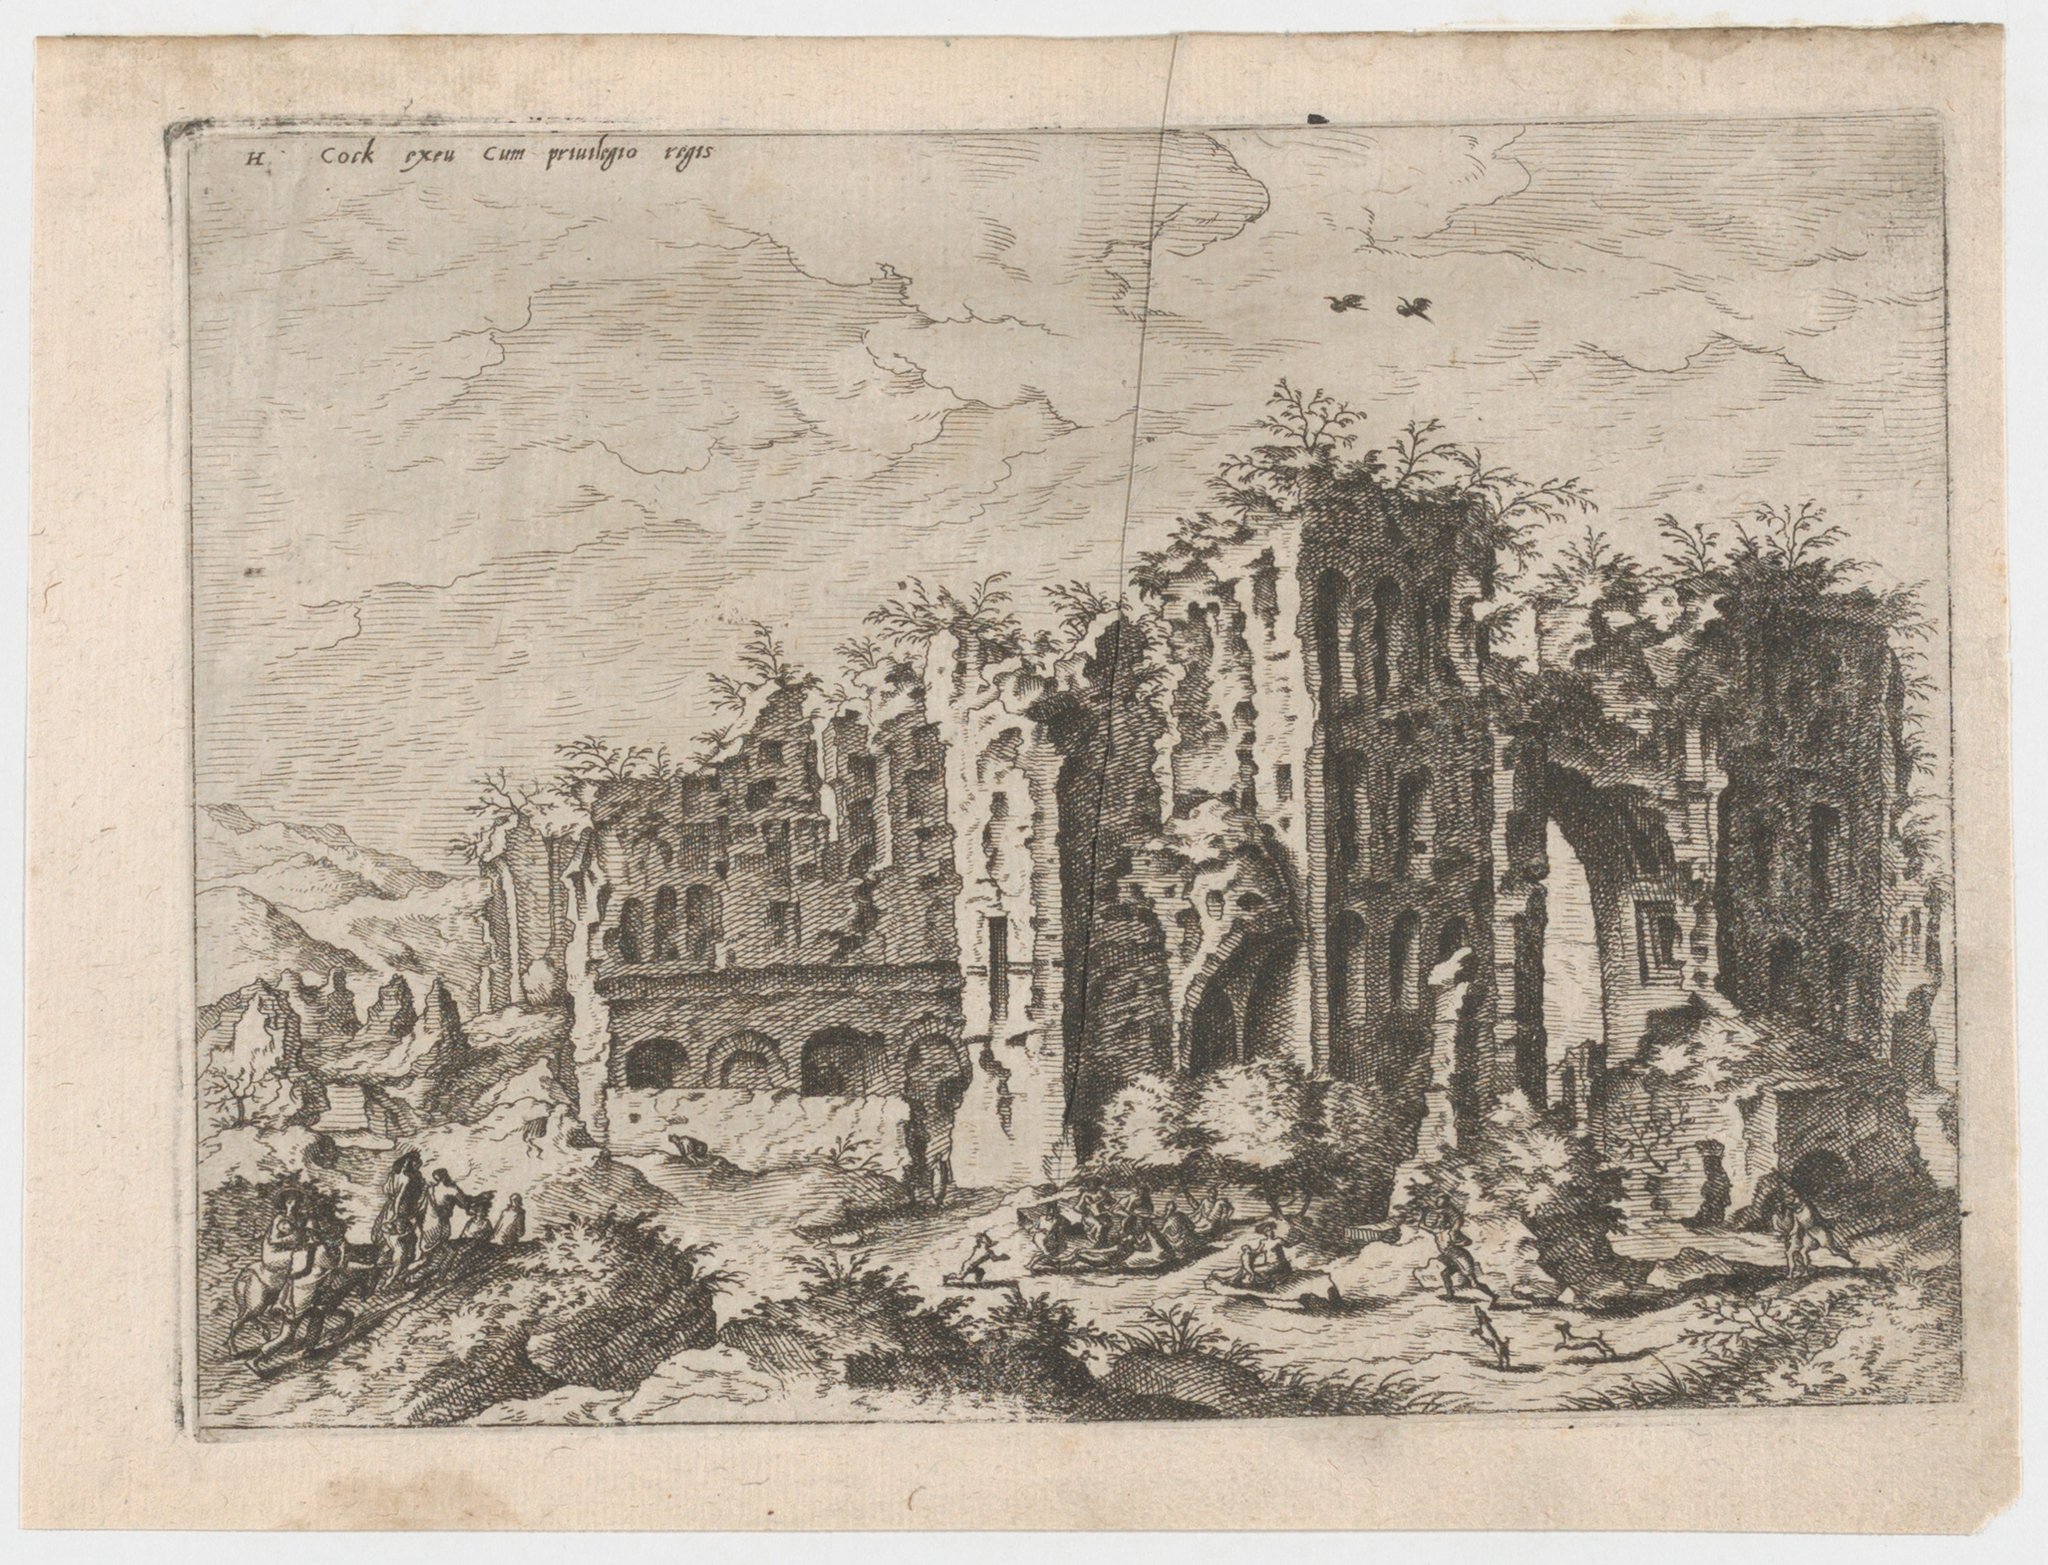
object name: print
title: Massive Ruins with Many Figures in the Foreground, from "Roman Ruins and Buildings"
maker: johannes van doetecum i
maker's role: artist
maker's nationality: netherlandish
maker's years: 1528-1605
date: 1562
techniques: etching